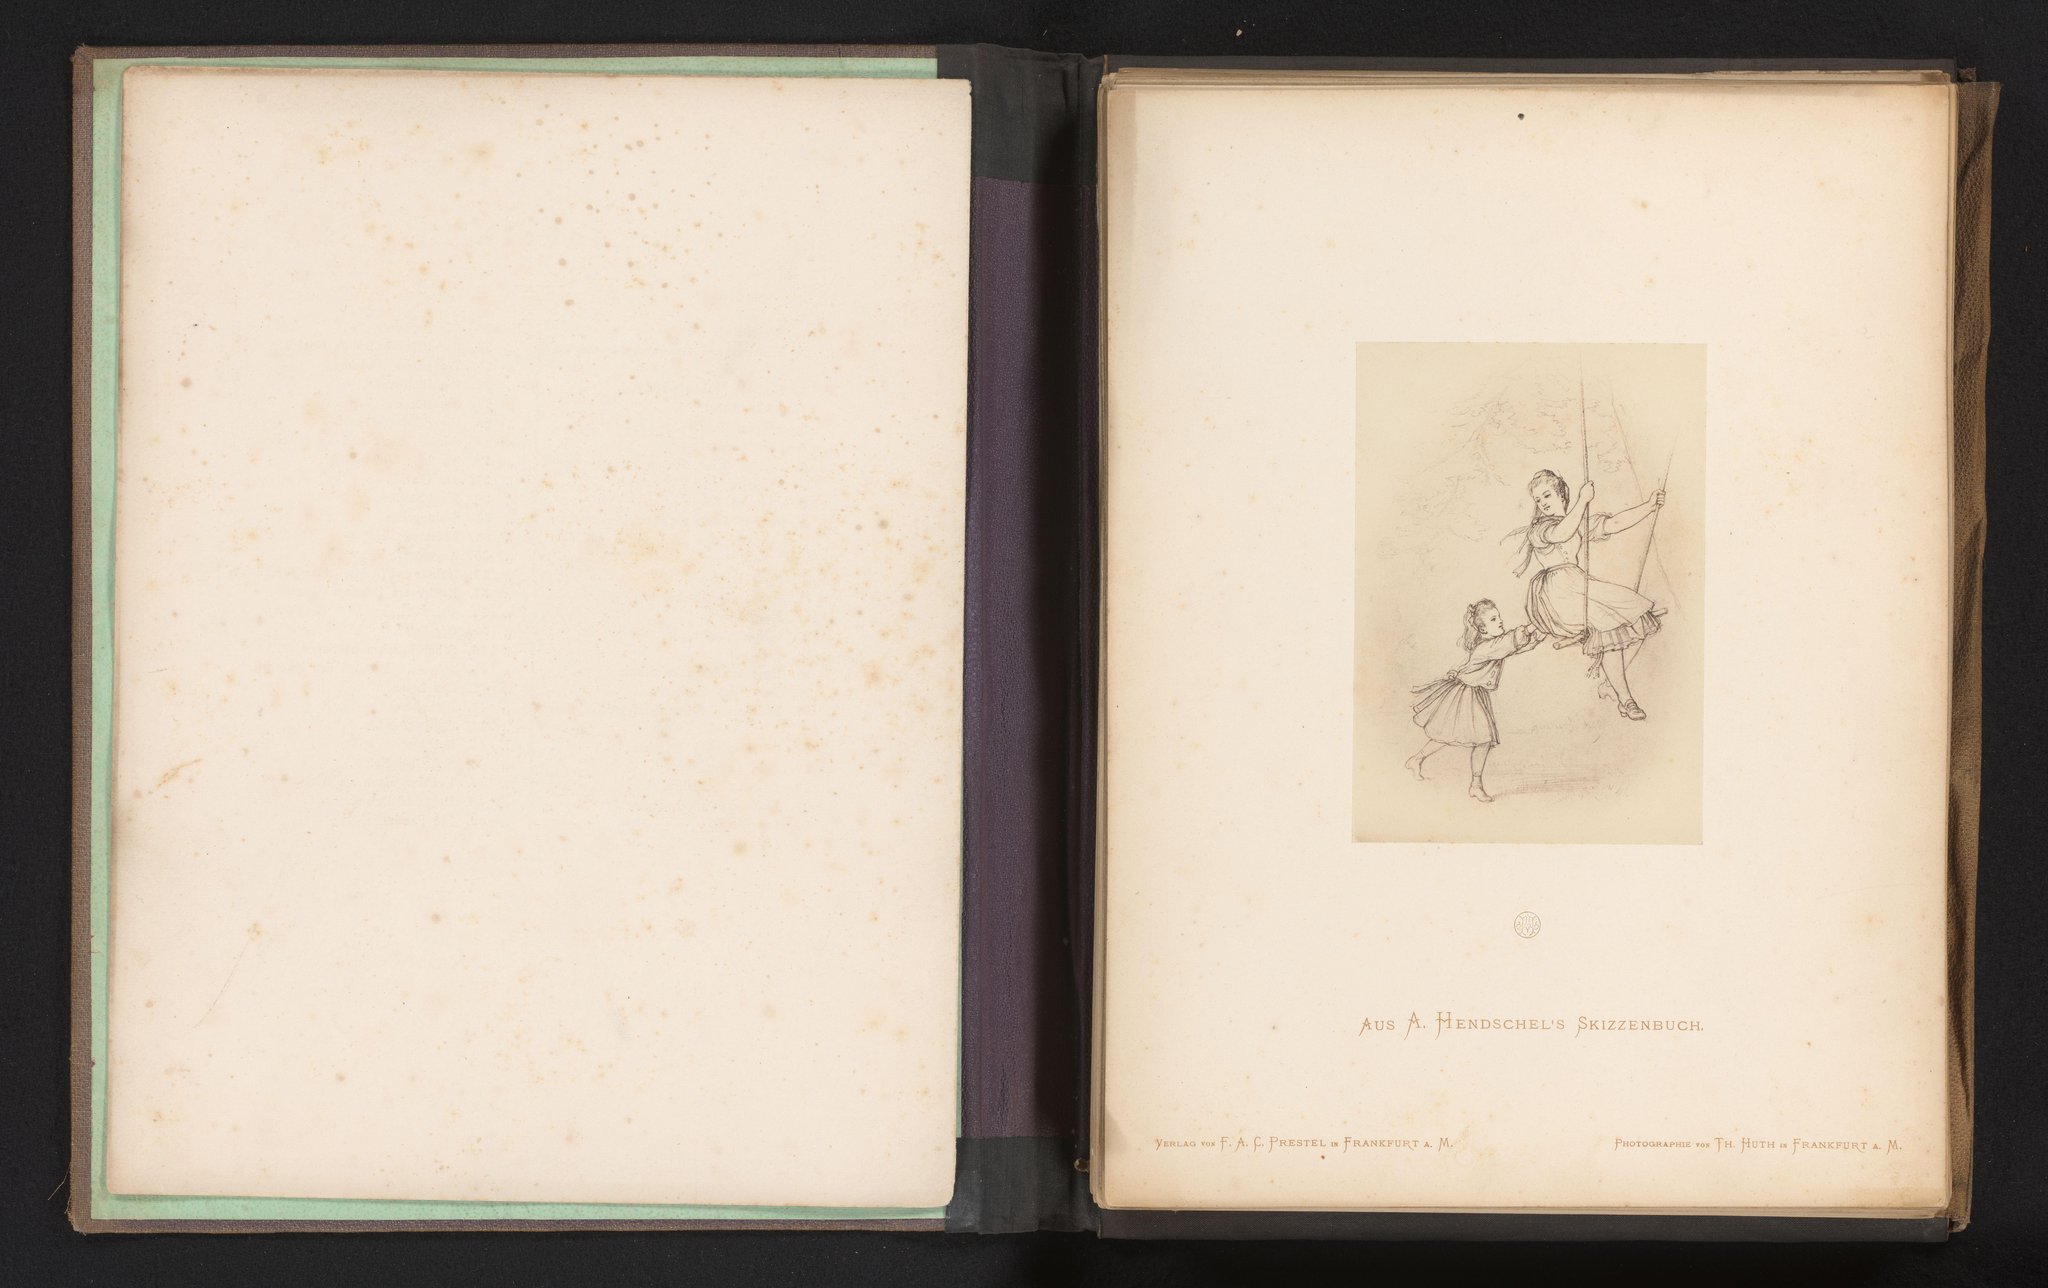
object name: reproduction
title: Fotoreproductie van een schets van een schommelend meisje door Albert Hendschel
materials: paper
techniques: albumen print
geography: frankfurt am main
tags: girl (child between toddler and youth) (+ two persons), swinging (children's game)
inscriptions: monogram: ‘AH’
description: Deze foto maakt deel uit van een omslag met 50 foto's op 48 bladen, een lijst van afbeeldingen en een titelblad.